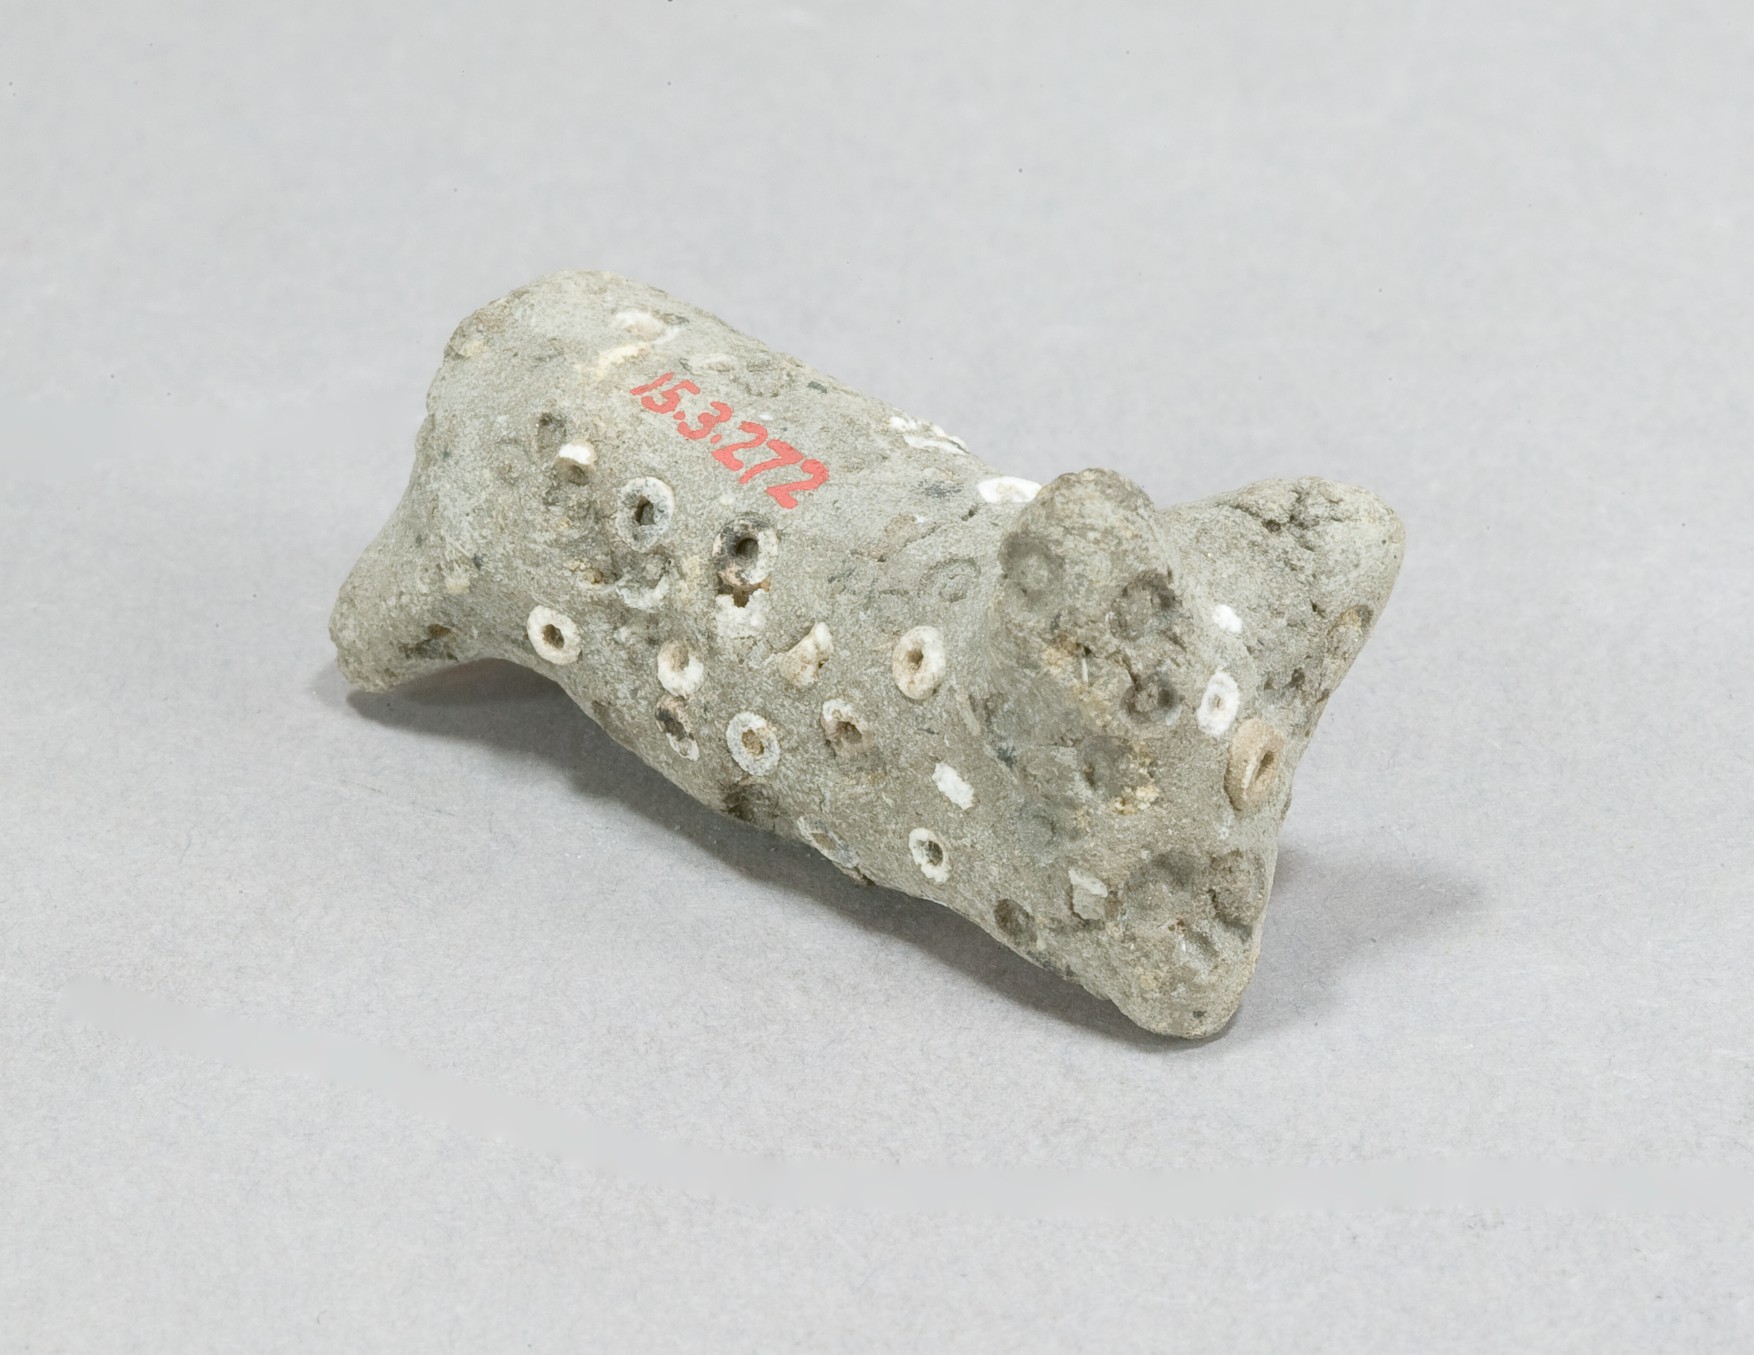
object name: figurine, animal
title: Animal figure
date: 1850-1640 BCE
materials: faience, mud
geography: egypt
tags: animals